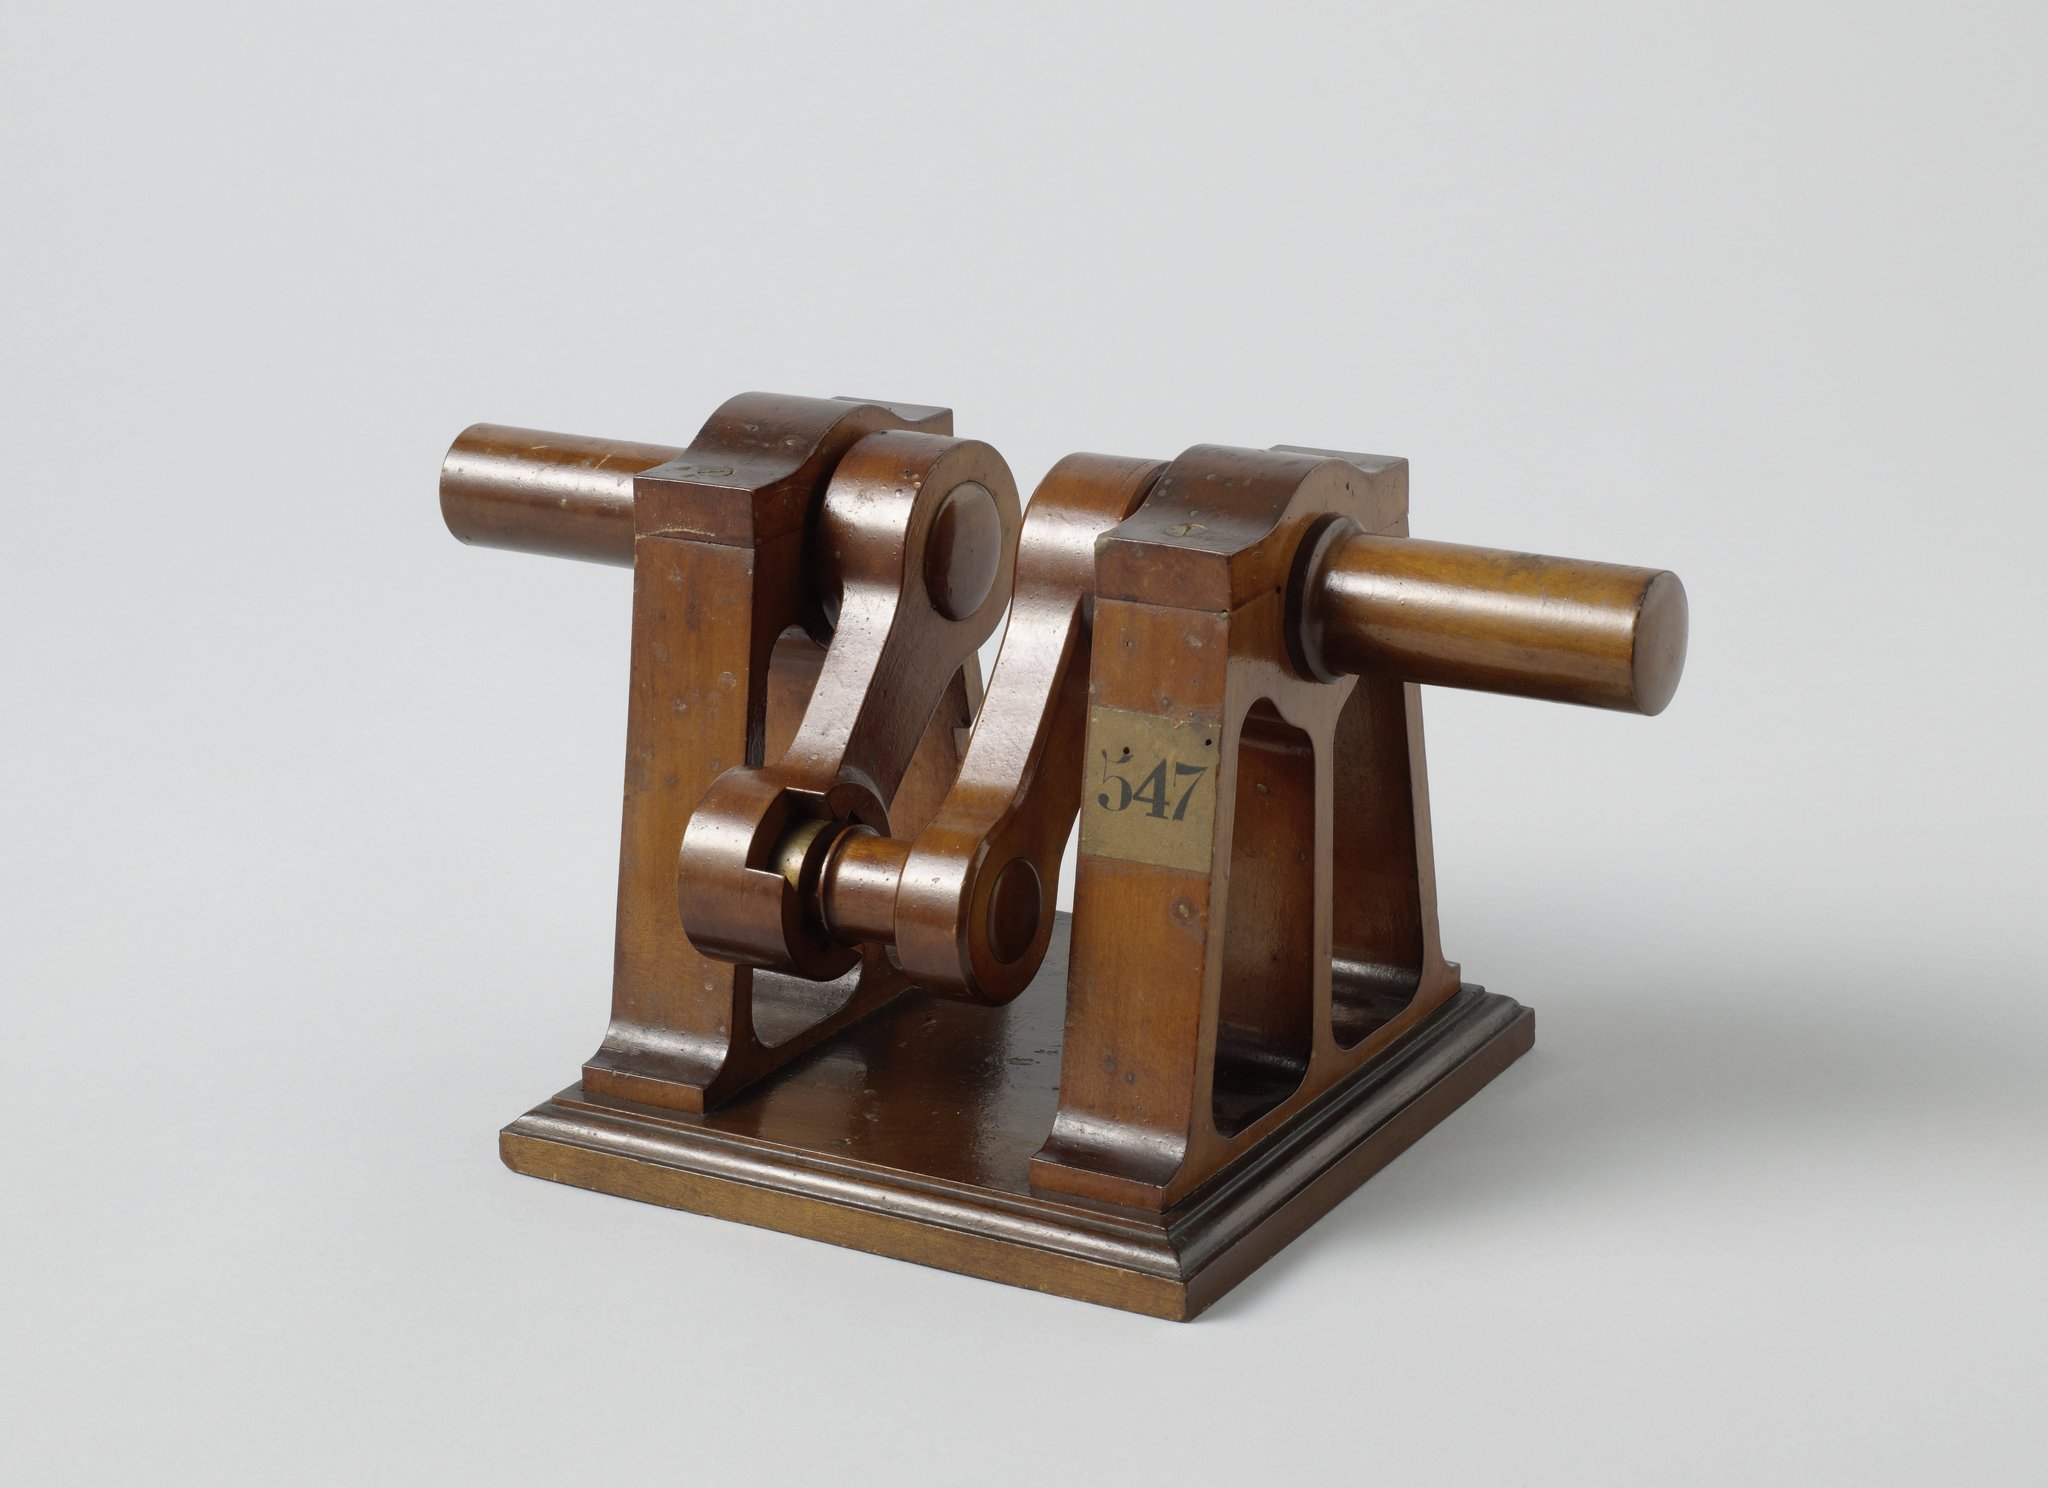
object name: demonstration model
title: Model of a Disengaging Gear for Paddle Wheels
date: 1840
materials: brass, wood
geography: united kingdom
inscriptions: label, on the frame: ‘547’ former inventory label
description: Model van de ontkoppeling van de krukas van een scheprad, op een grondplank. De pen van de kruk valt in een holle bus in het oog van de kruk van de rader-as, die losgeschroefd kan worden en verwijderd en daarmee de as ontkoppelt. Bij iedere slag beweegt de pen van de kruk daarna vrij door de gleuf van de raderkruk, die op de plaats van de bus is opengebleven. Schaal 1:10 (afgeleid).